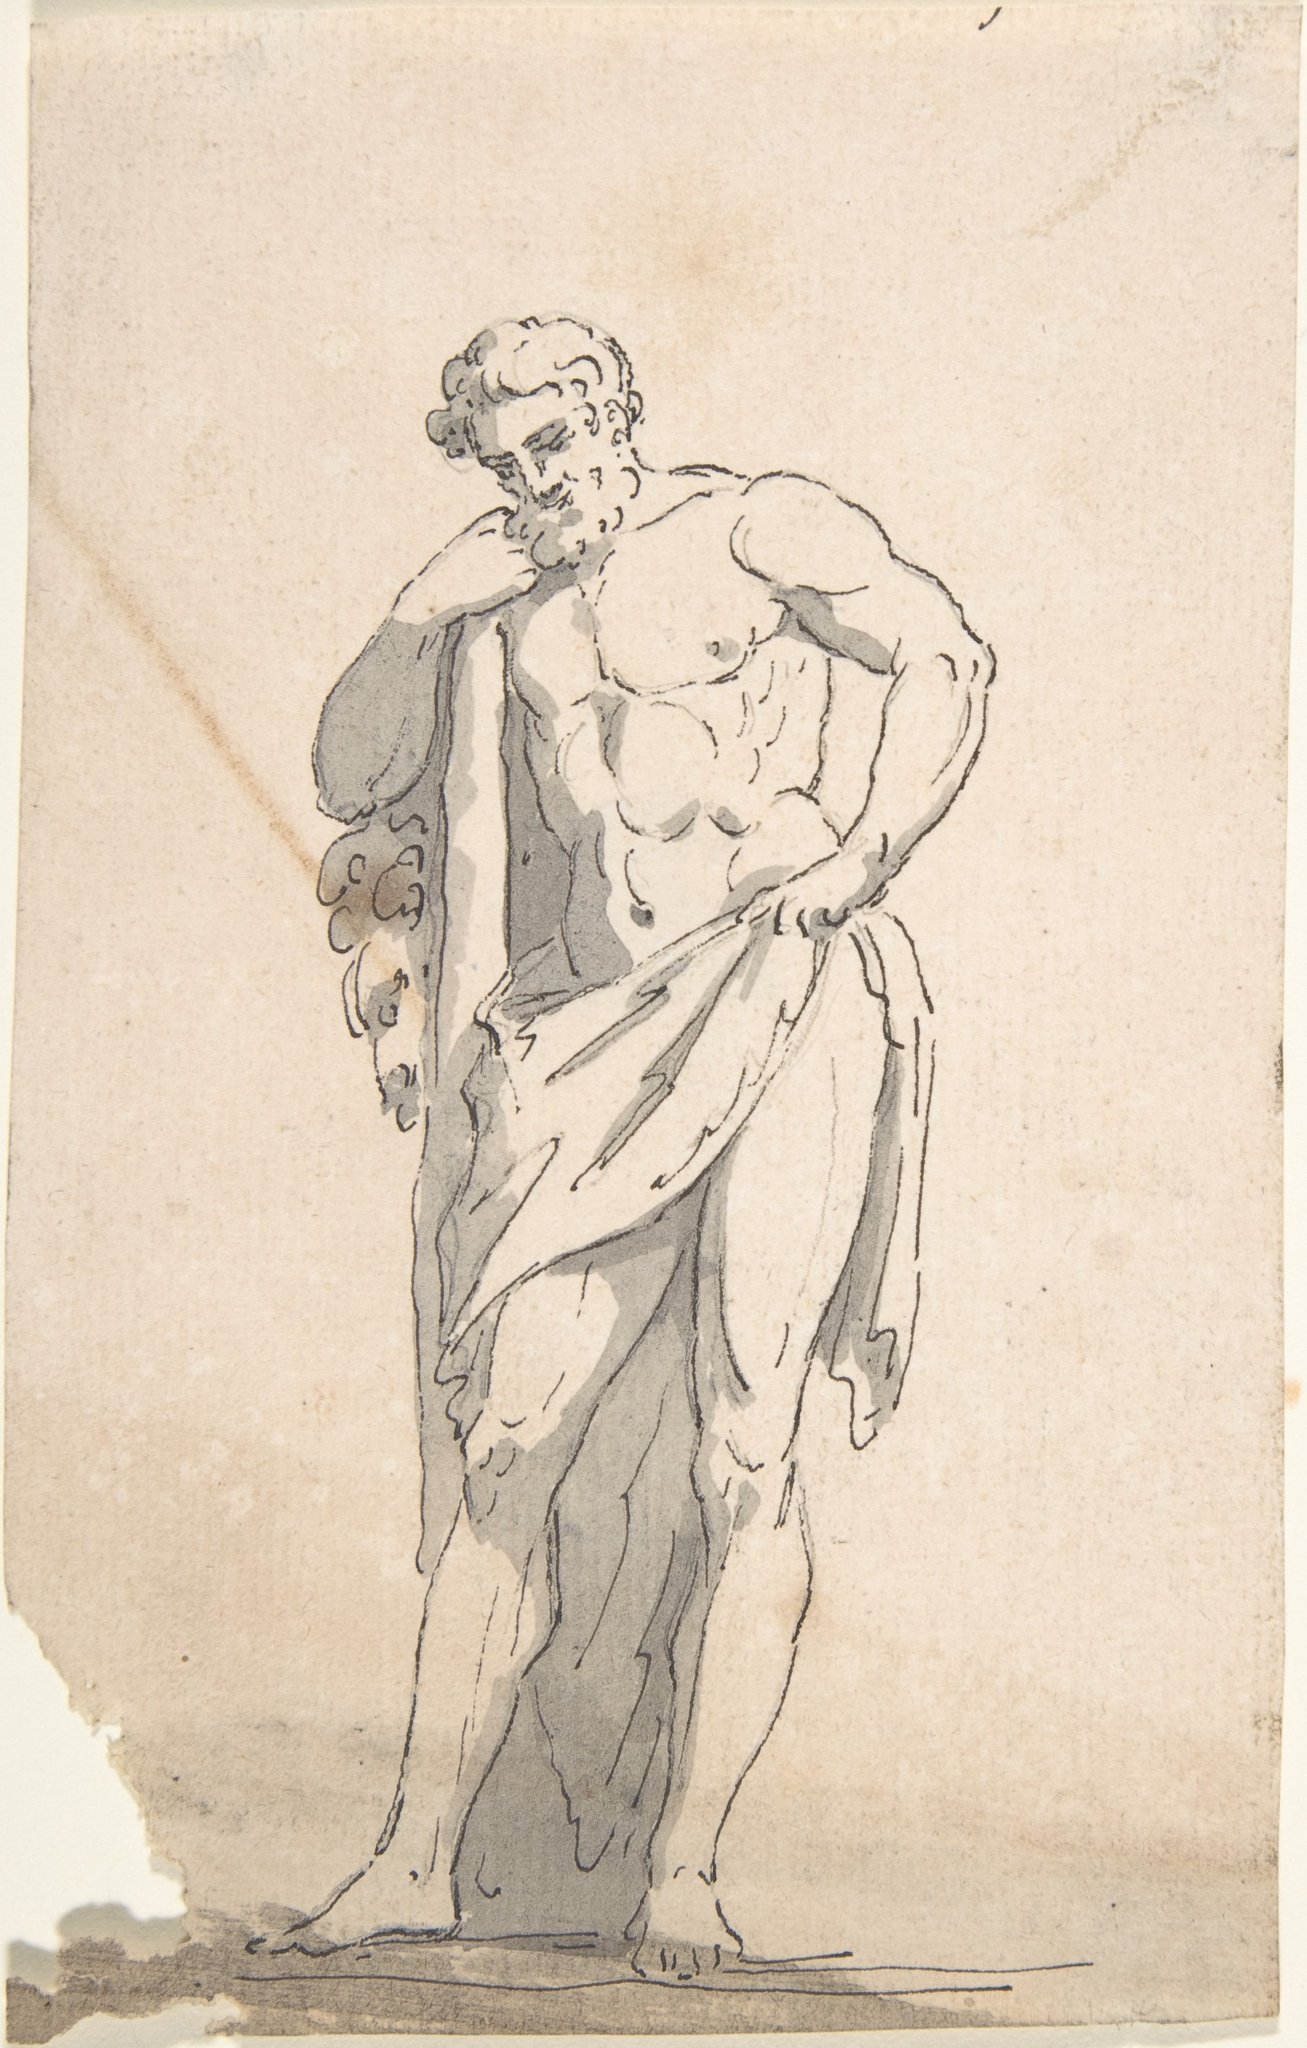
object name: drawing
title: Drawing after Male Statue Leaning on Tree Trunk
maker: anonymous, french, 18th century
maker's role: artist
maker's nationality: french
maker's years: 1700-1800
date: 1701-1800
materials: graphite, ink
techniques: brush, pen, wash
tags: men